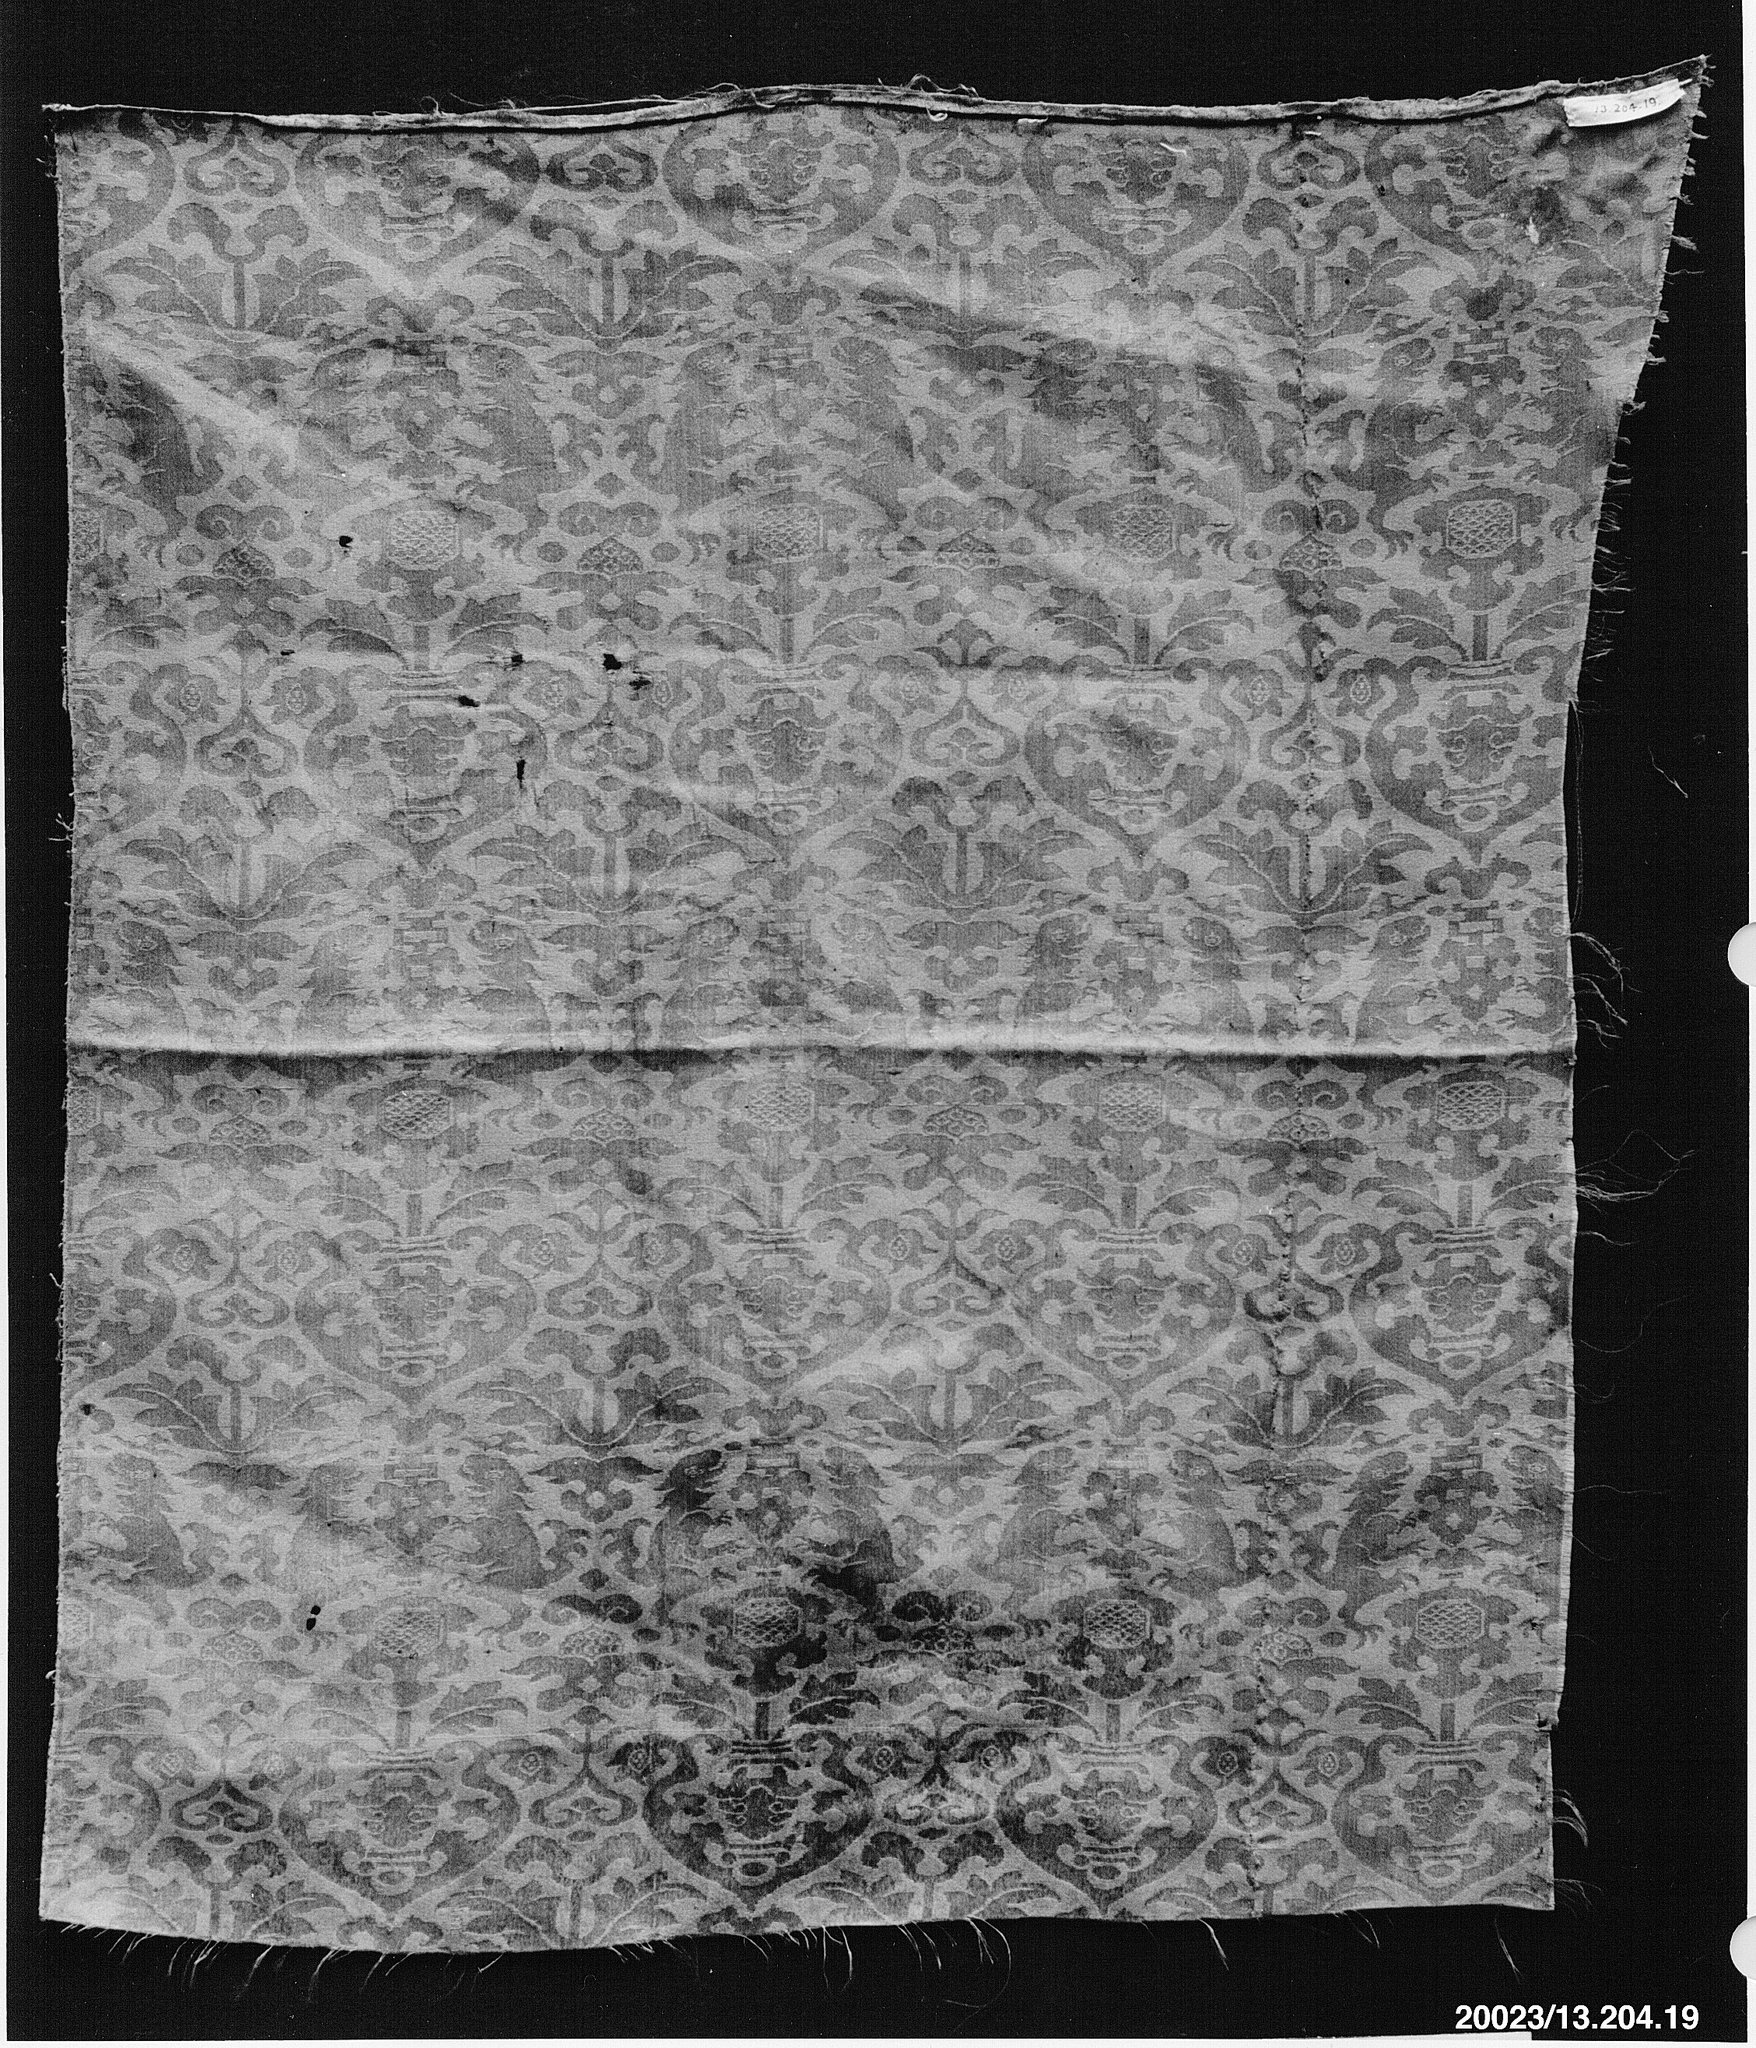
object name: piece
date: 1501-1600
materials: silk